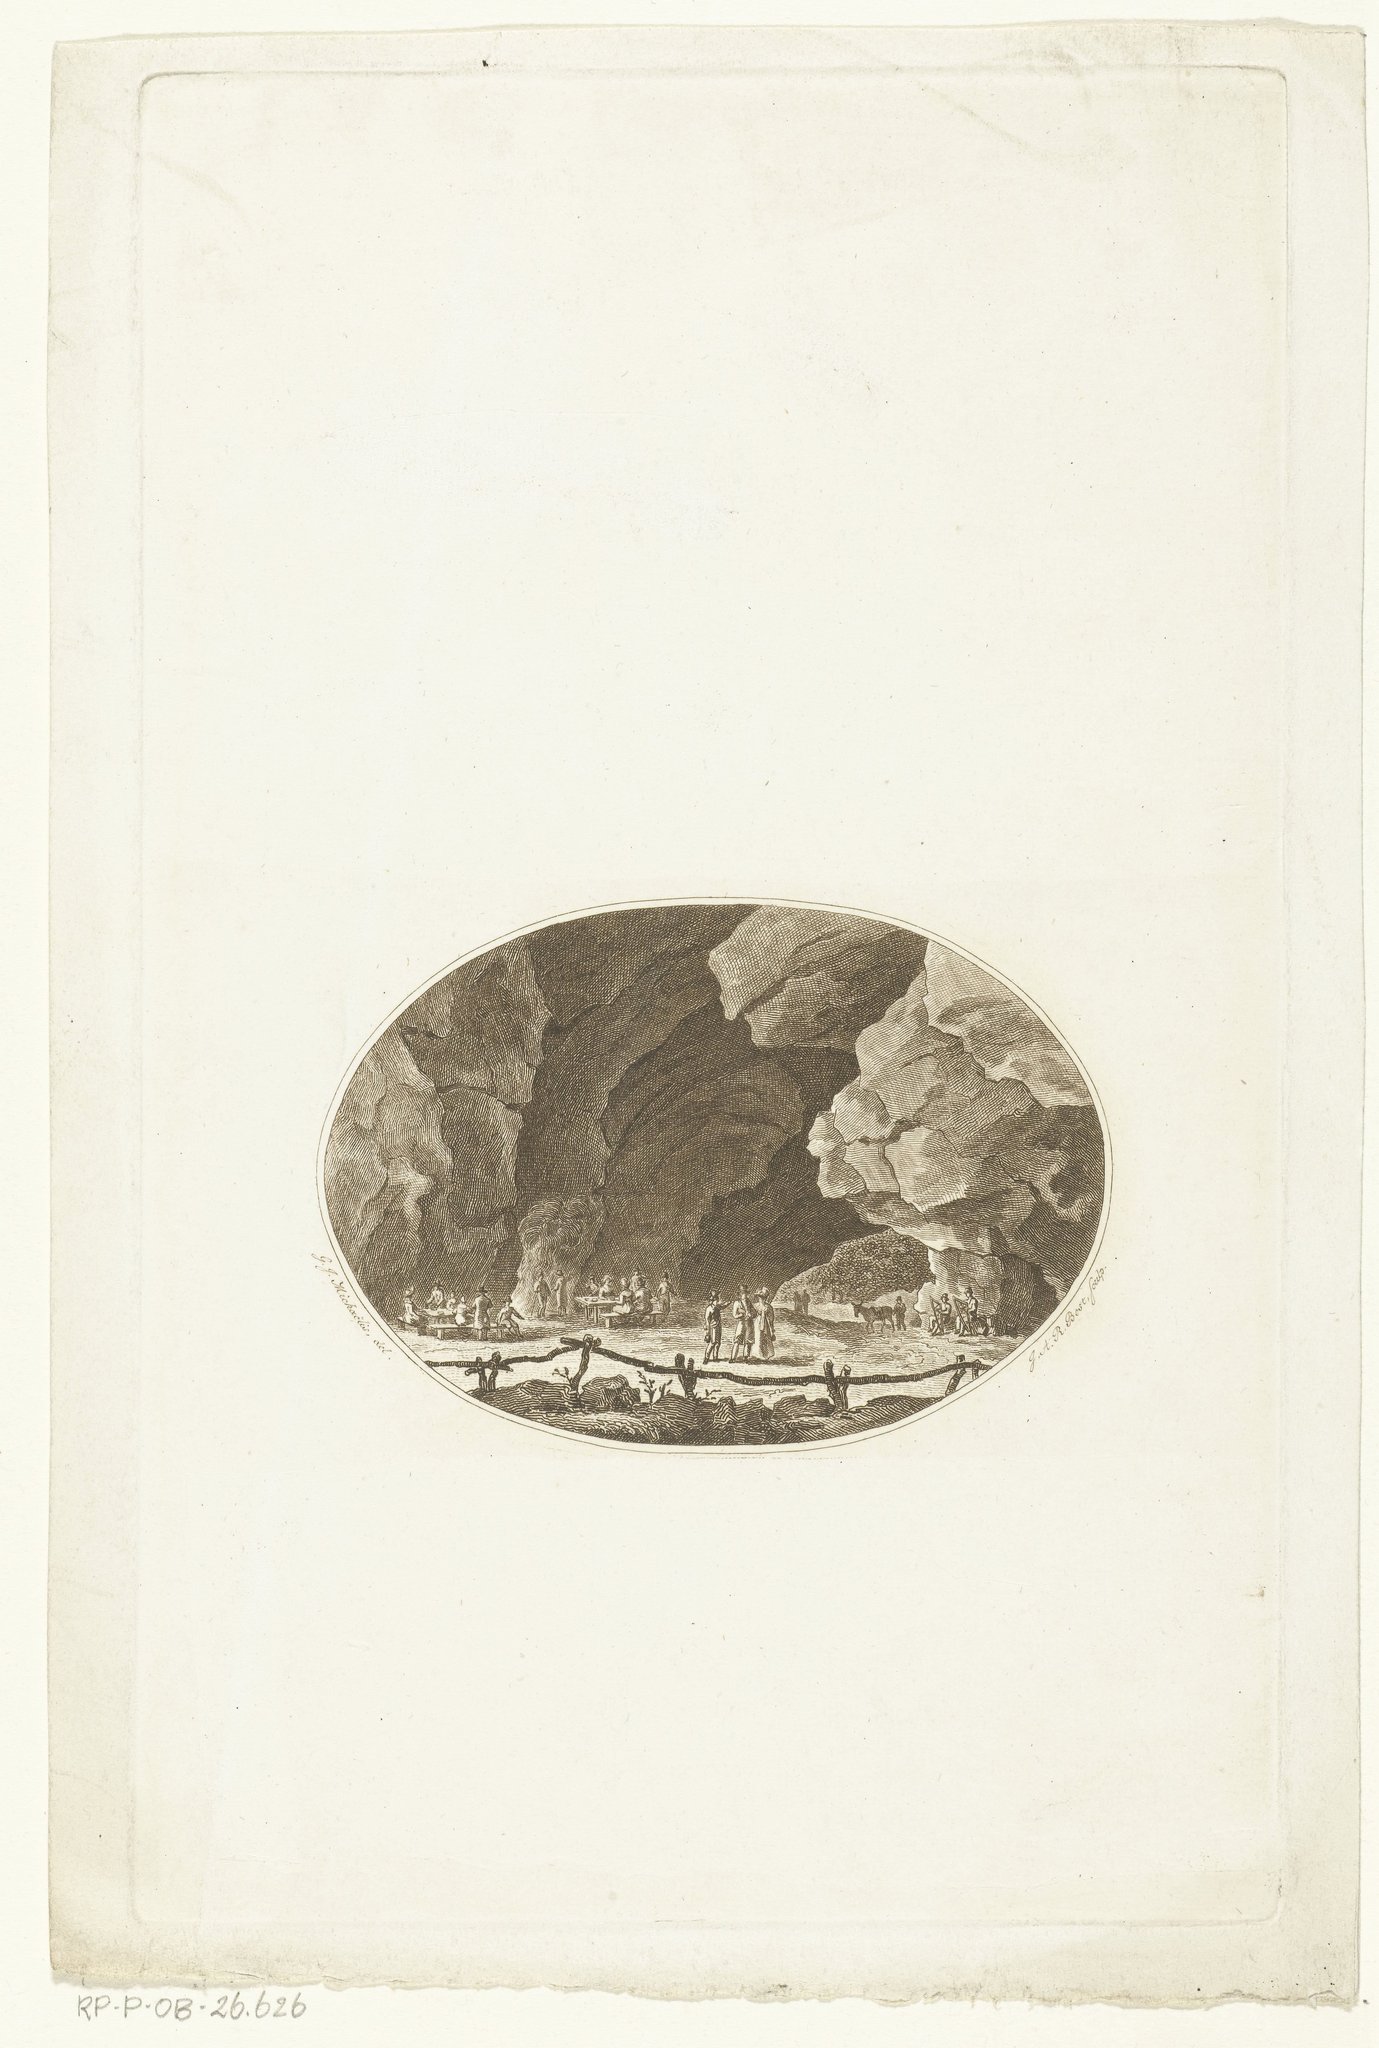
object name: print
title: Gezelschap bij een grot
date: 1807-1855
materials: paper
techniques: etching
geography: amsterdam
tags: cave, grotto, cultural tour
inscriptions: collector's mark: Lugt 2228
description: Proefdruk van prent welke werd gebruikt als titelpagina in onbekende uitgave.